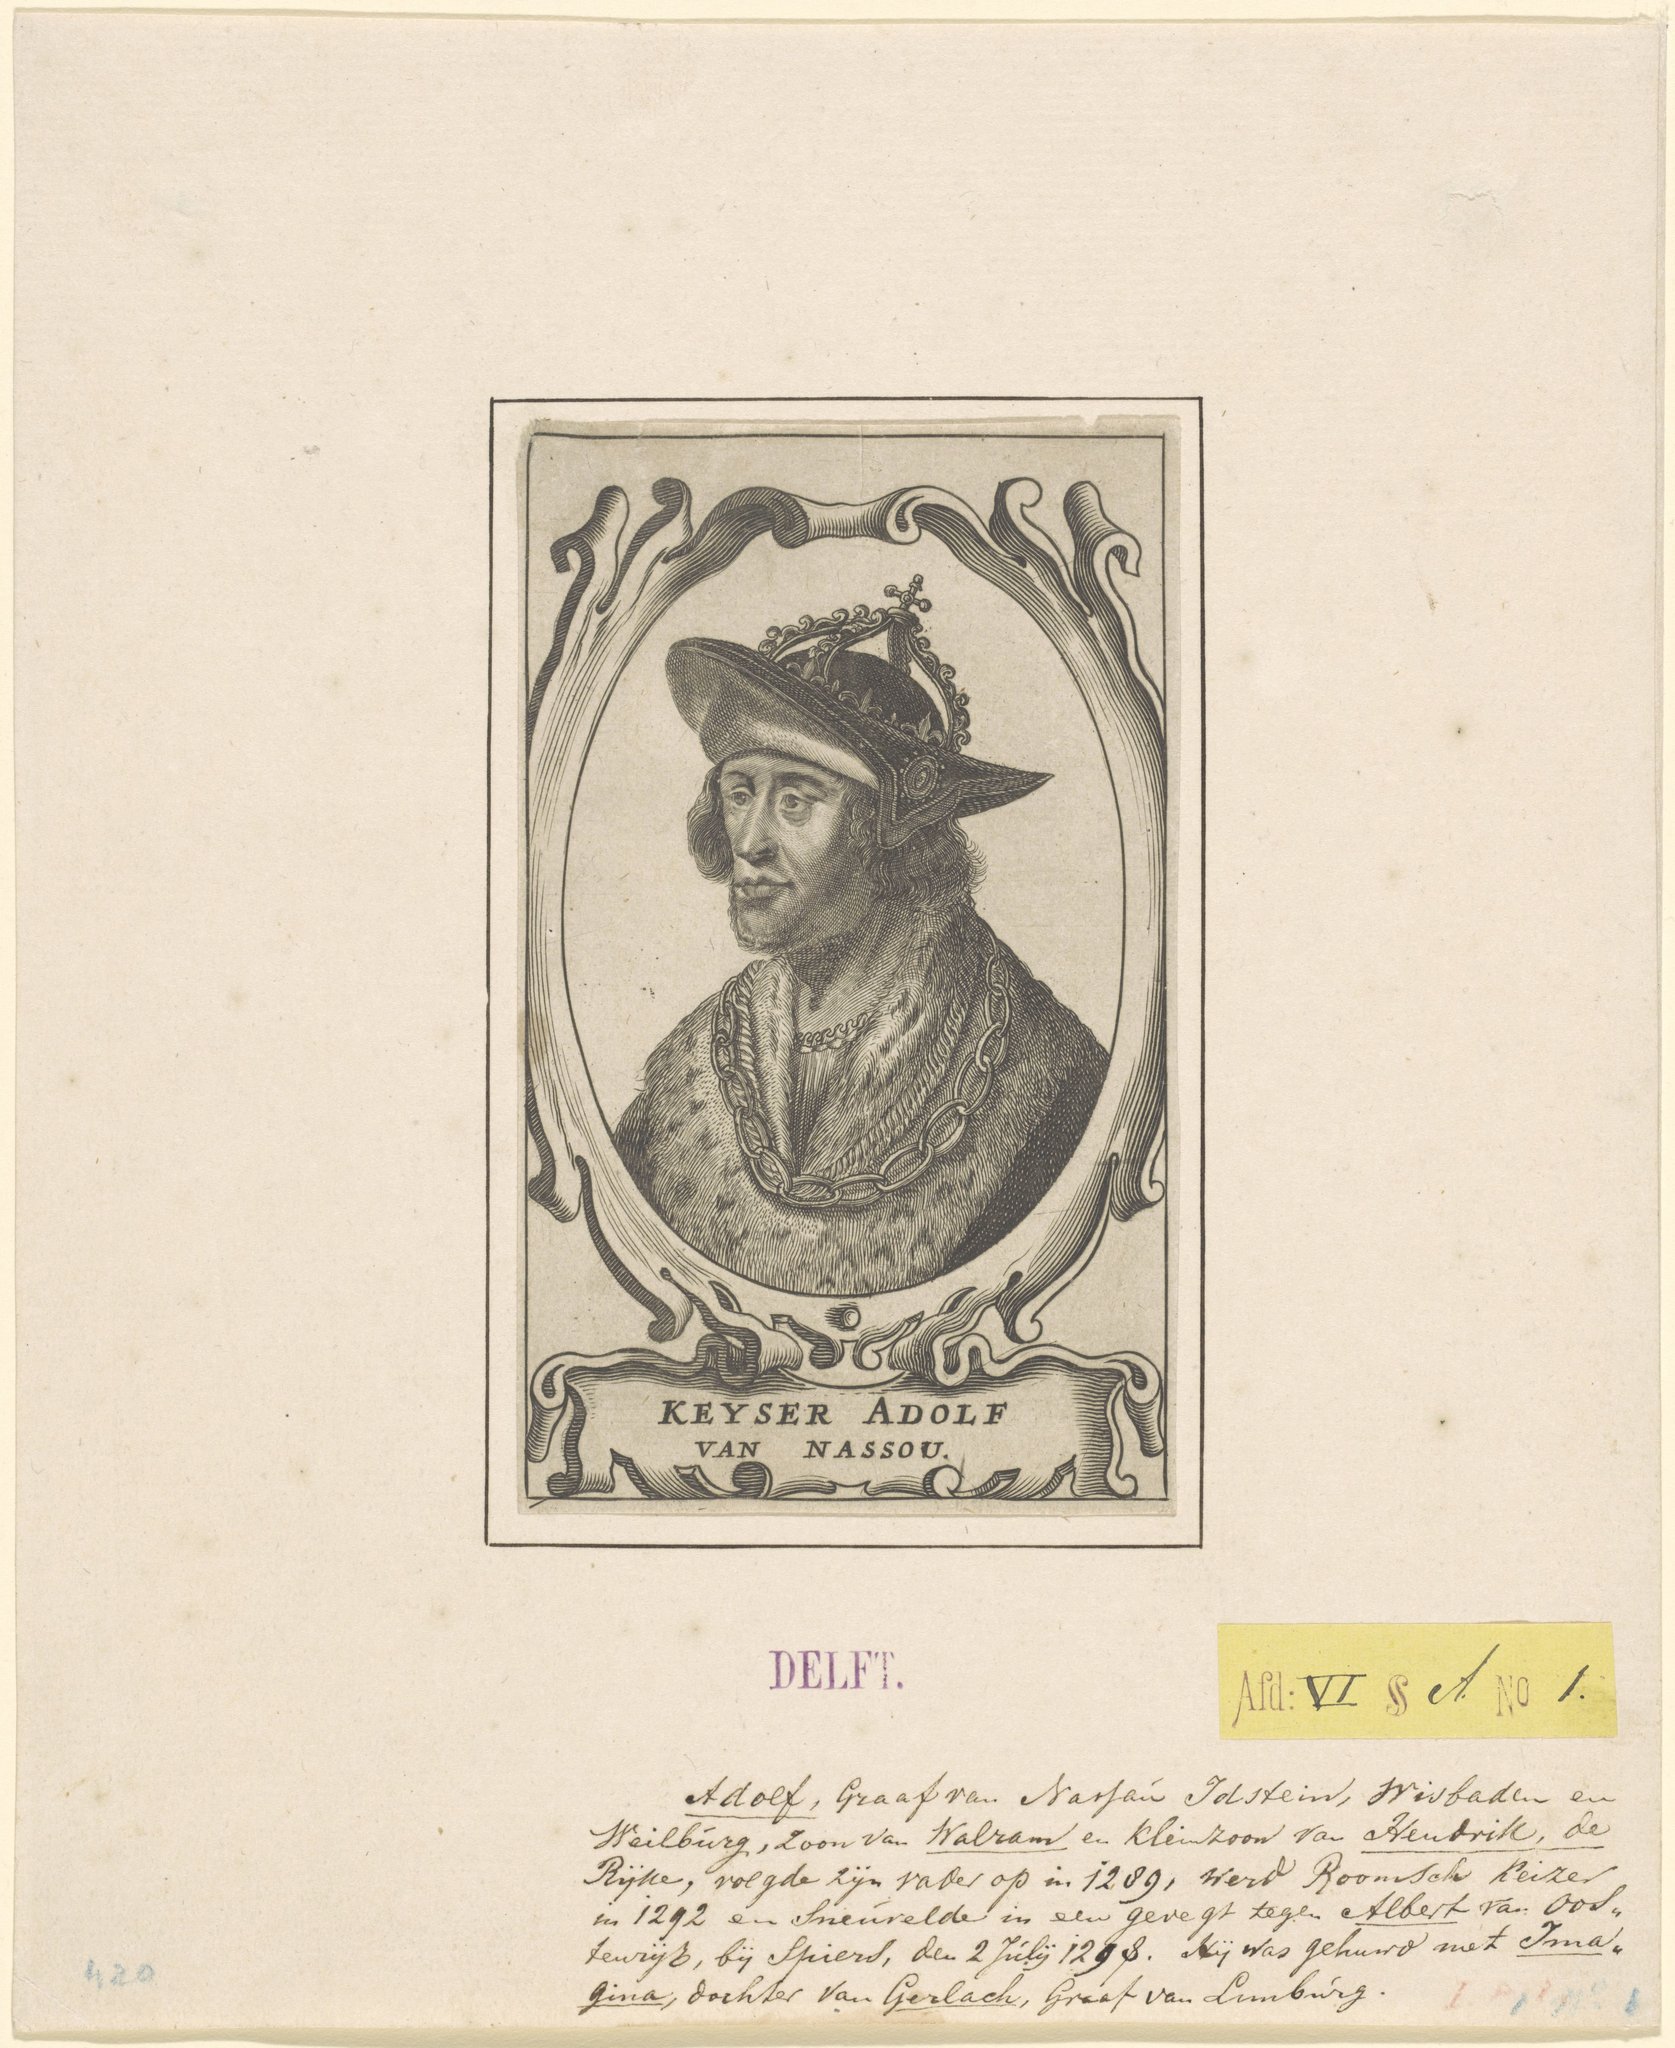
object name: print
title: Portret van Adolf, graaf van Nassau en Rooms-Duits koning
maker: Anonymous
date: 1600-1699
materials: paper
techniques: engraving, etching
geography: low countries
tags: gelnheim, koning, adolf (graaf van nassau en rooms-duits koning)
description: De hier vermelde titel verwijst naar de hoogst verkregen titel van de geportretteerde, niet per se naar de titel die de geportretteerde op deze voorstelling draagt.